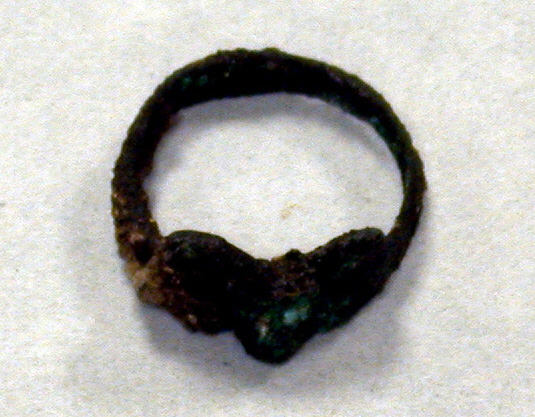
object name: ring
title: Copper Ring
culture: peruvian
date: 1401-1500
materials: copper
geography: peru